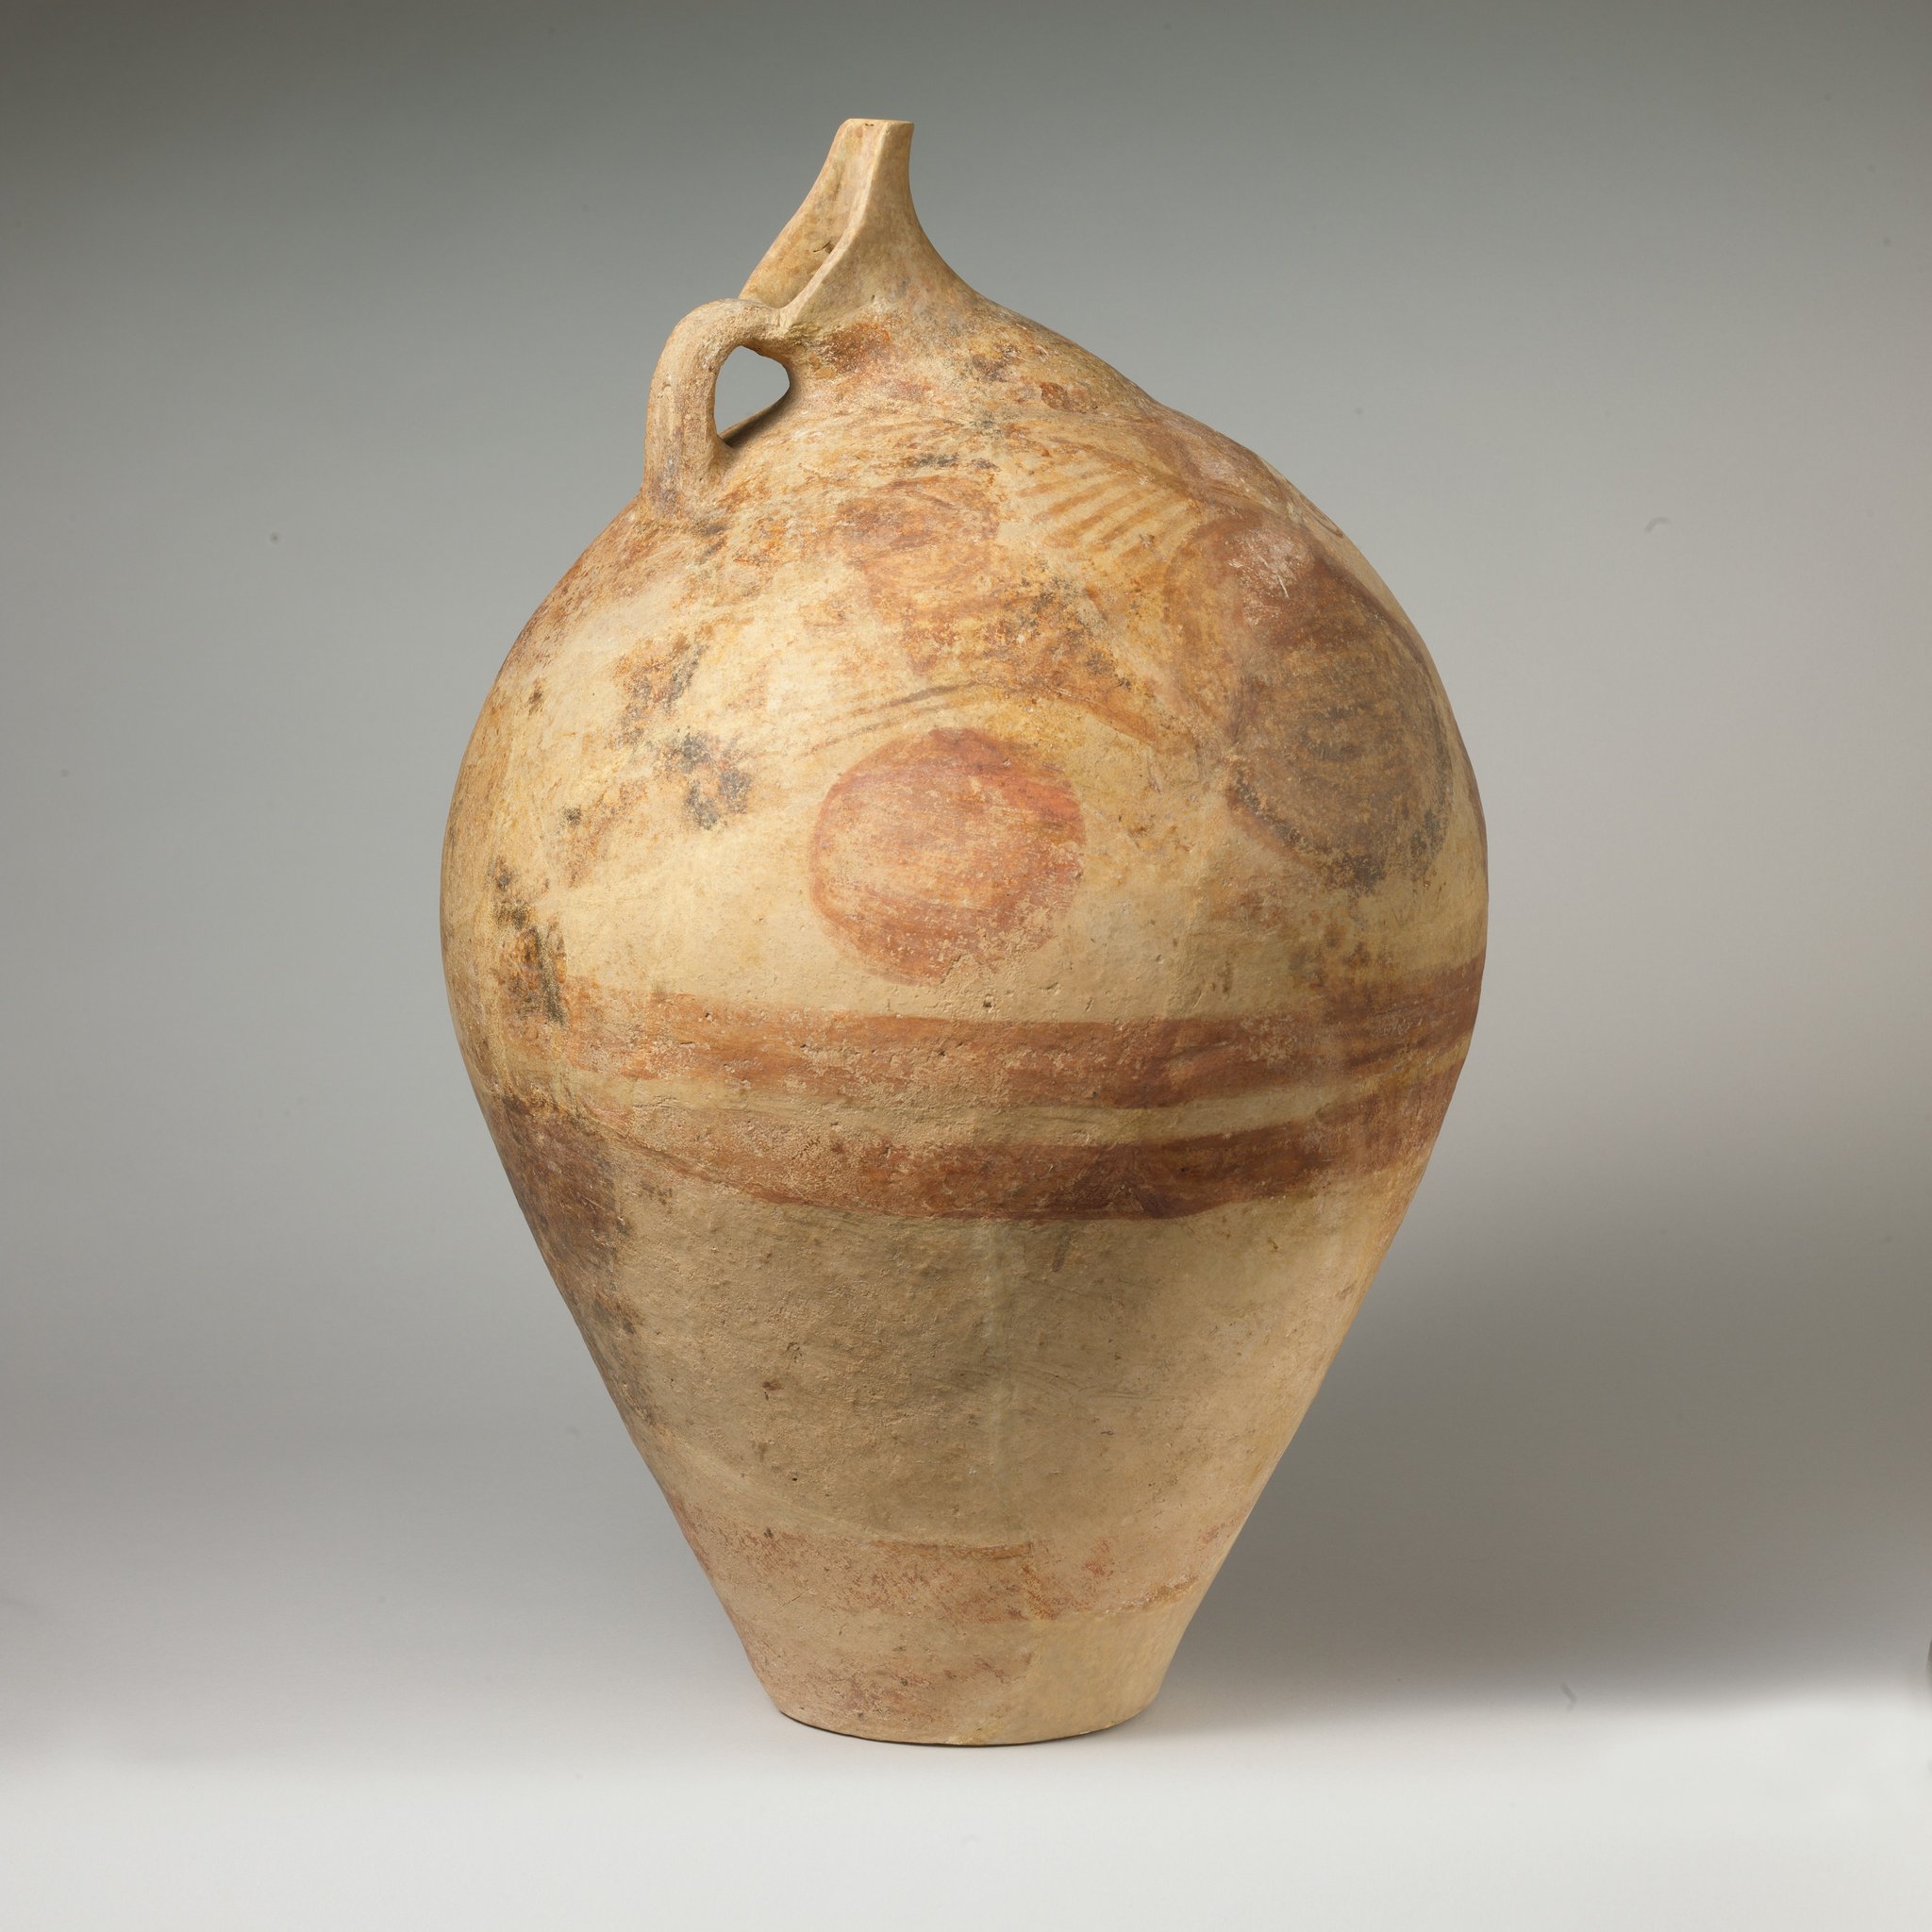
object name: jug beak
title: Terracotta beaked jug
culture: cycladic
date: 1700-1600 BCE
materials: terracotta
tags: birds